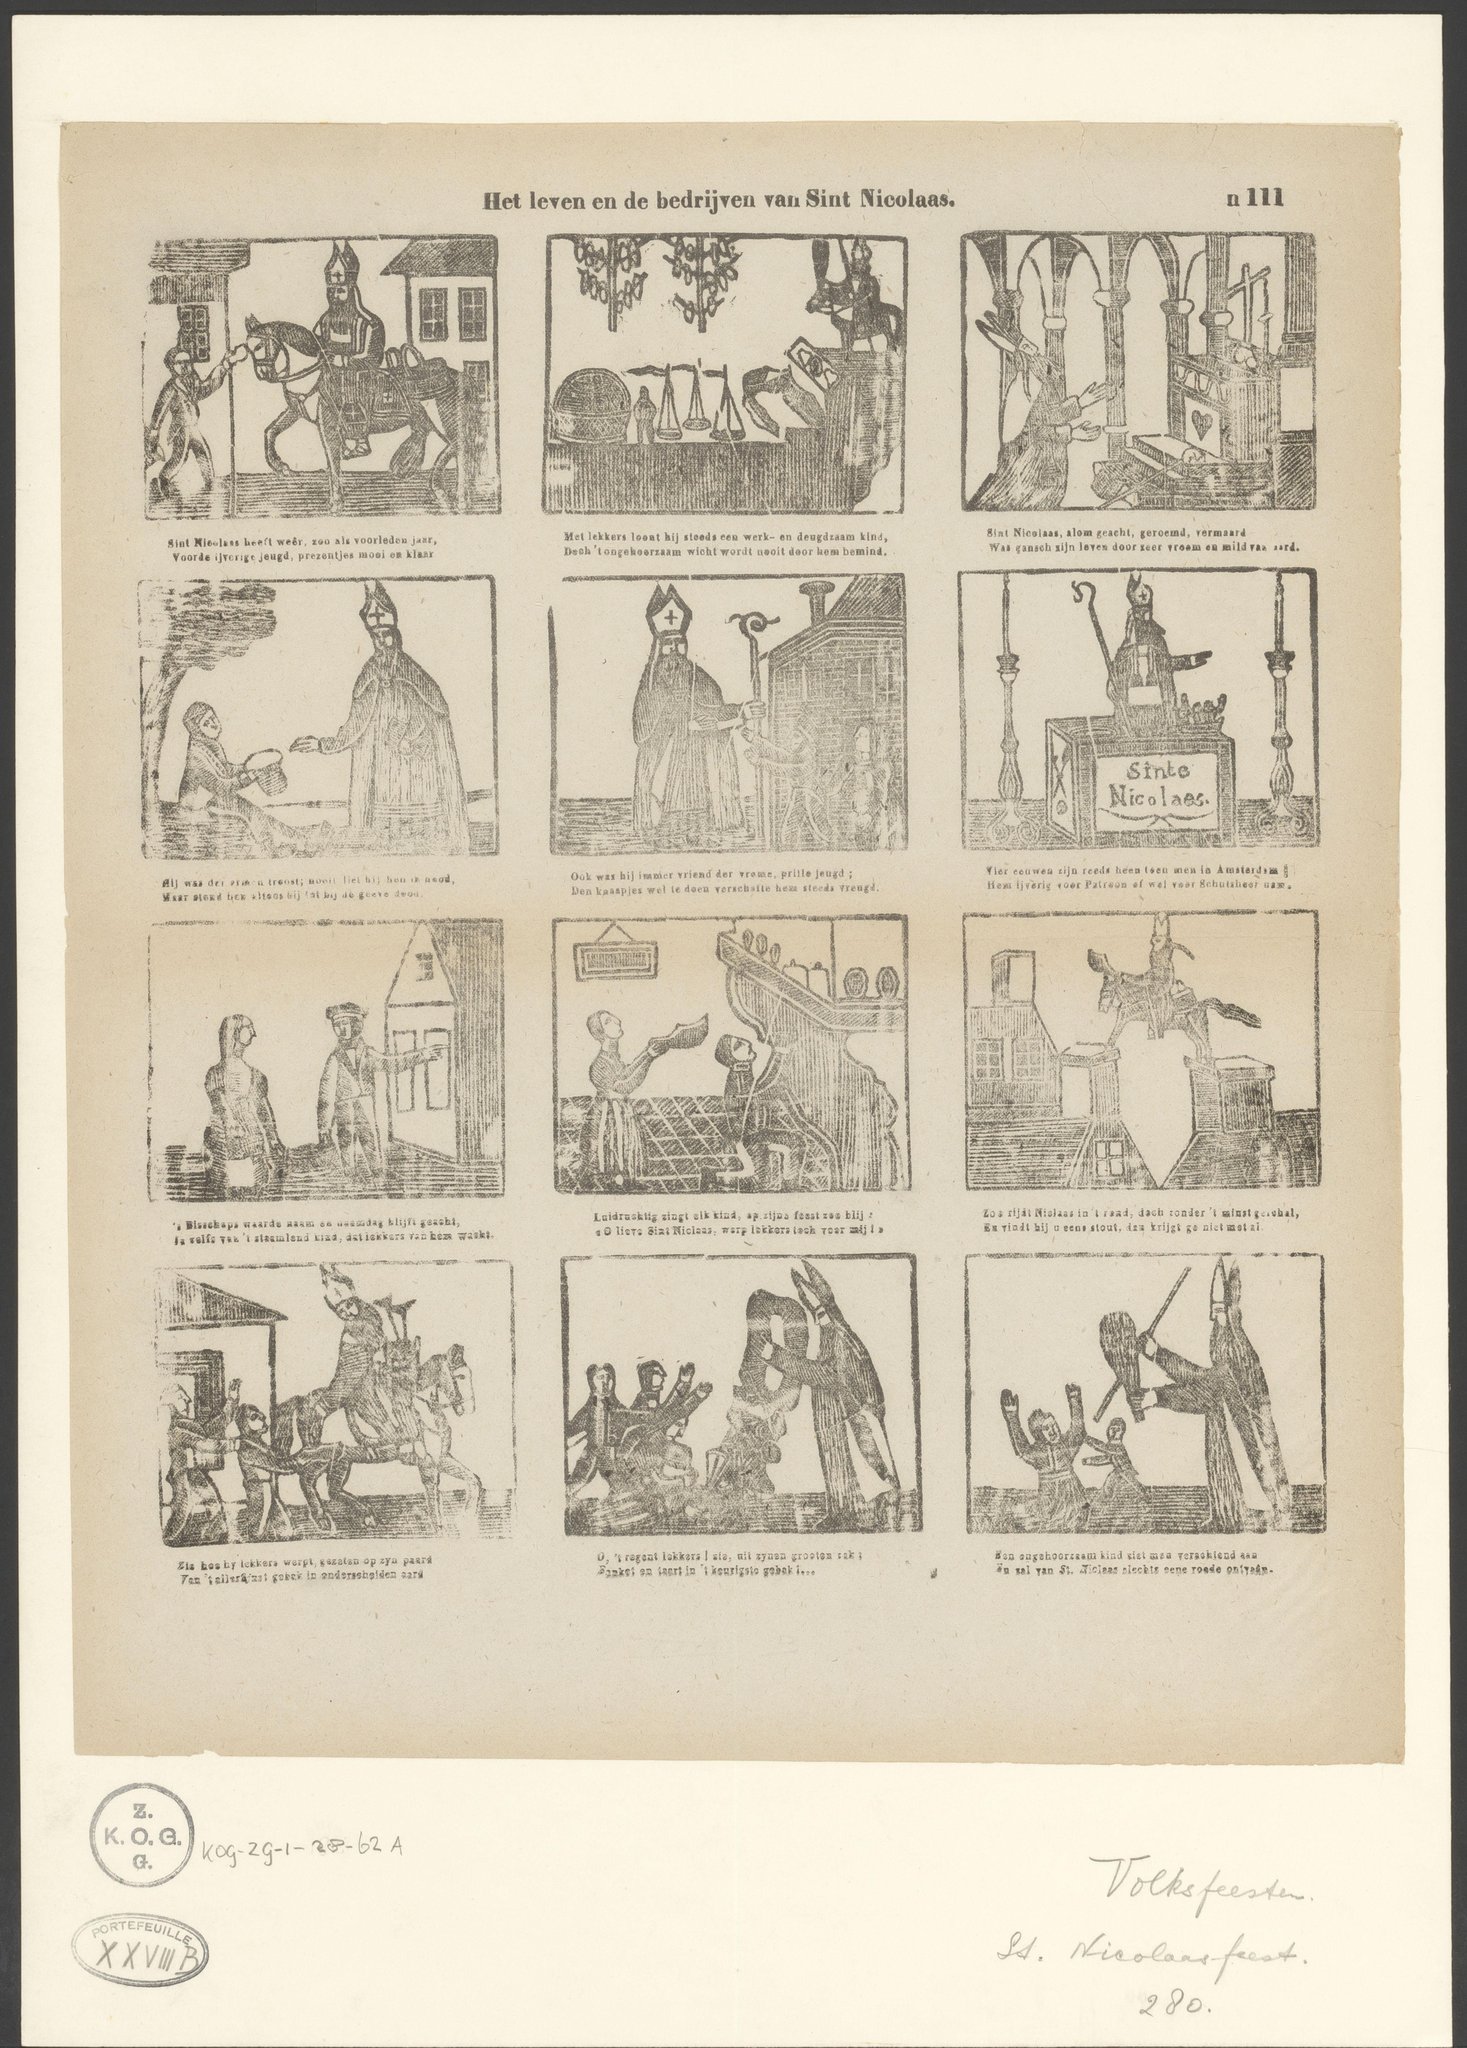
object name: print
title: Het leven en de bedrijven van Sint Nicolaas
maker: Anonymous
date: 1856-1900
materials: paper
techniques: letterpress printing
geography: turnhout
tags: the bishop nicholas of myra (or bari); possible attributes: anchor, boat, three golden balls (on a book), three purses, three children in a tub, three maidens, festivities on st. nicholas (eve) (december 5)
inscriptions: collector's mark: Lugt 1641, stamp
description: Twaalf voorstellingen uit het leven van Sint Nicolaas in drie kolommen. Onder iedere voorstelling twee regels tekst. Rechtsboven genummerd: N111. Onderwerpsrubrieken binnen de Atlas Zeden en Gewoonten: Zeden en Gewoonten in Engeren Zin. Volksleven. Volksfeesten. St. Nicolaas.